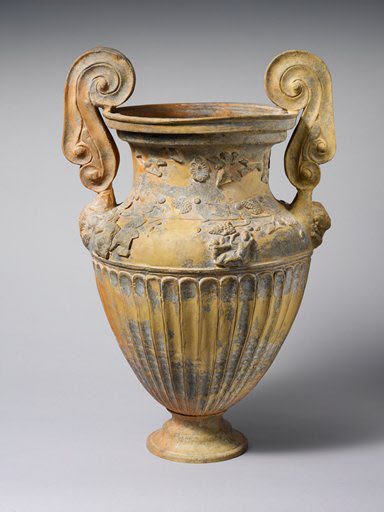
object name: volute krater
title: Terracotta volute-krater (bowl for mixing wine and water)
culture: etruscan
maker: bolsena group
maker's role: artist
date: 330-290 BCE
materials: terracotta